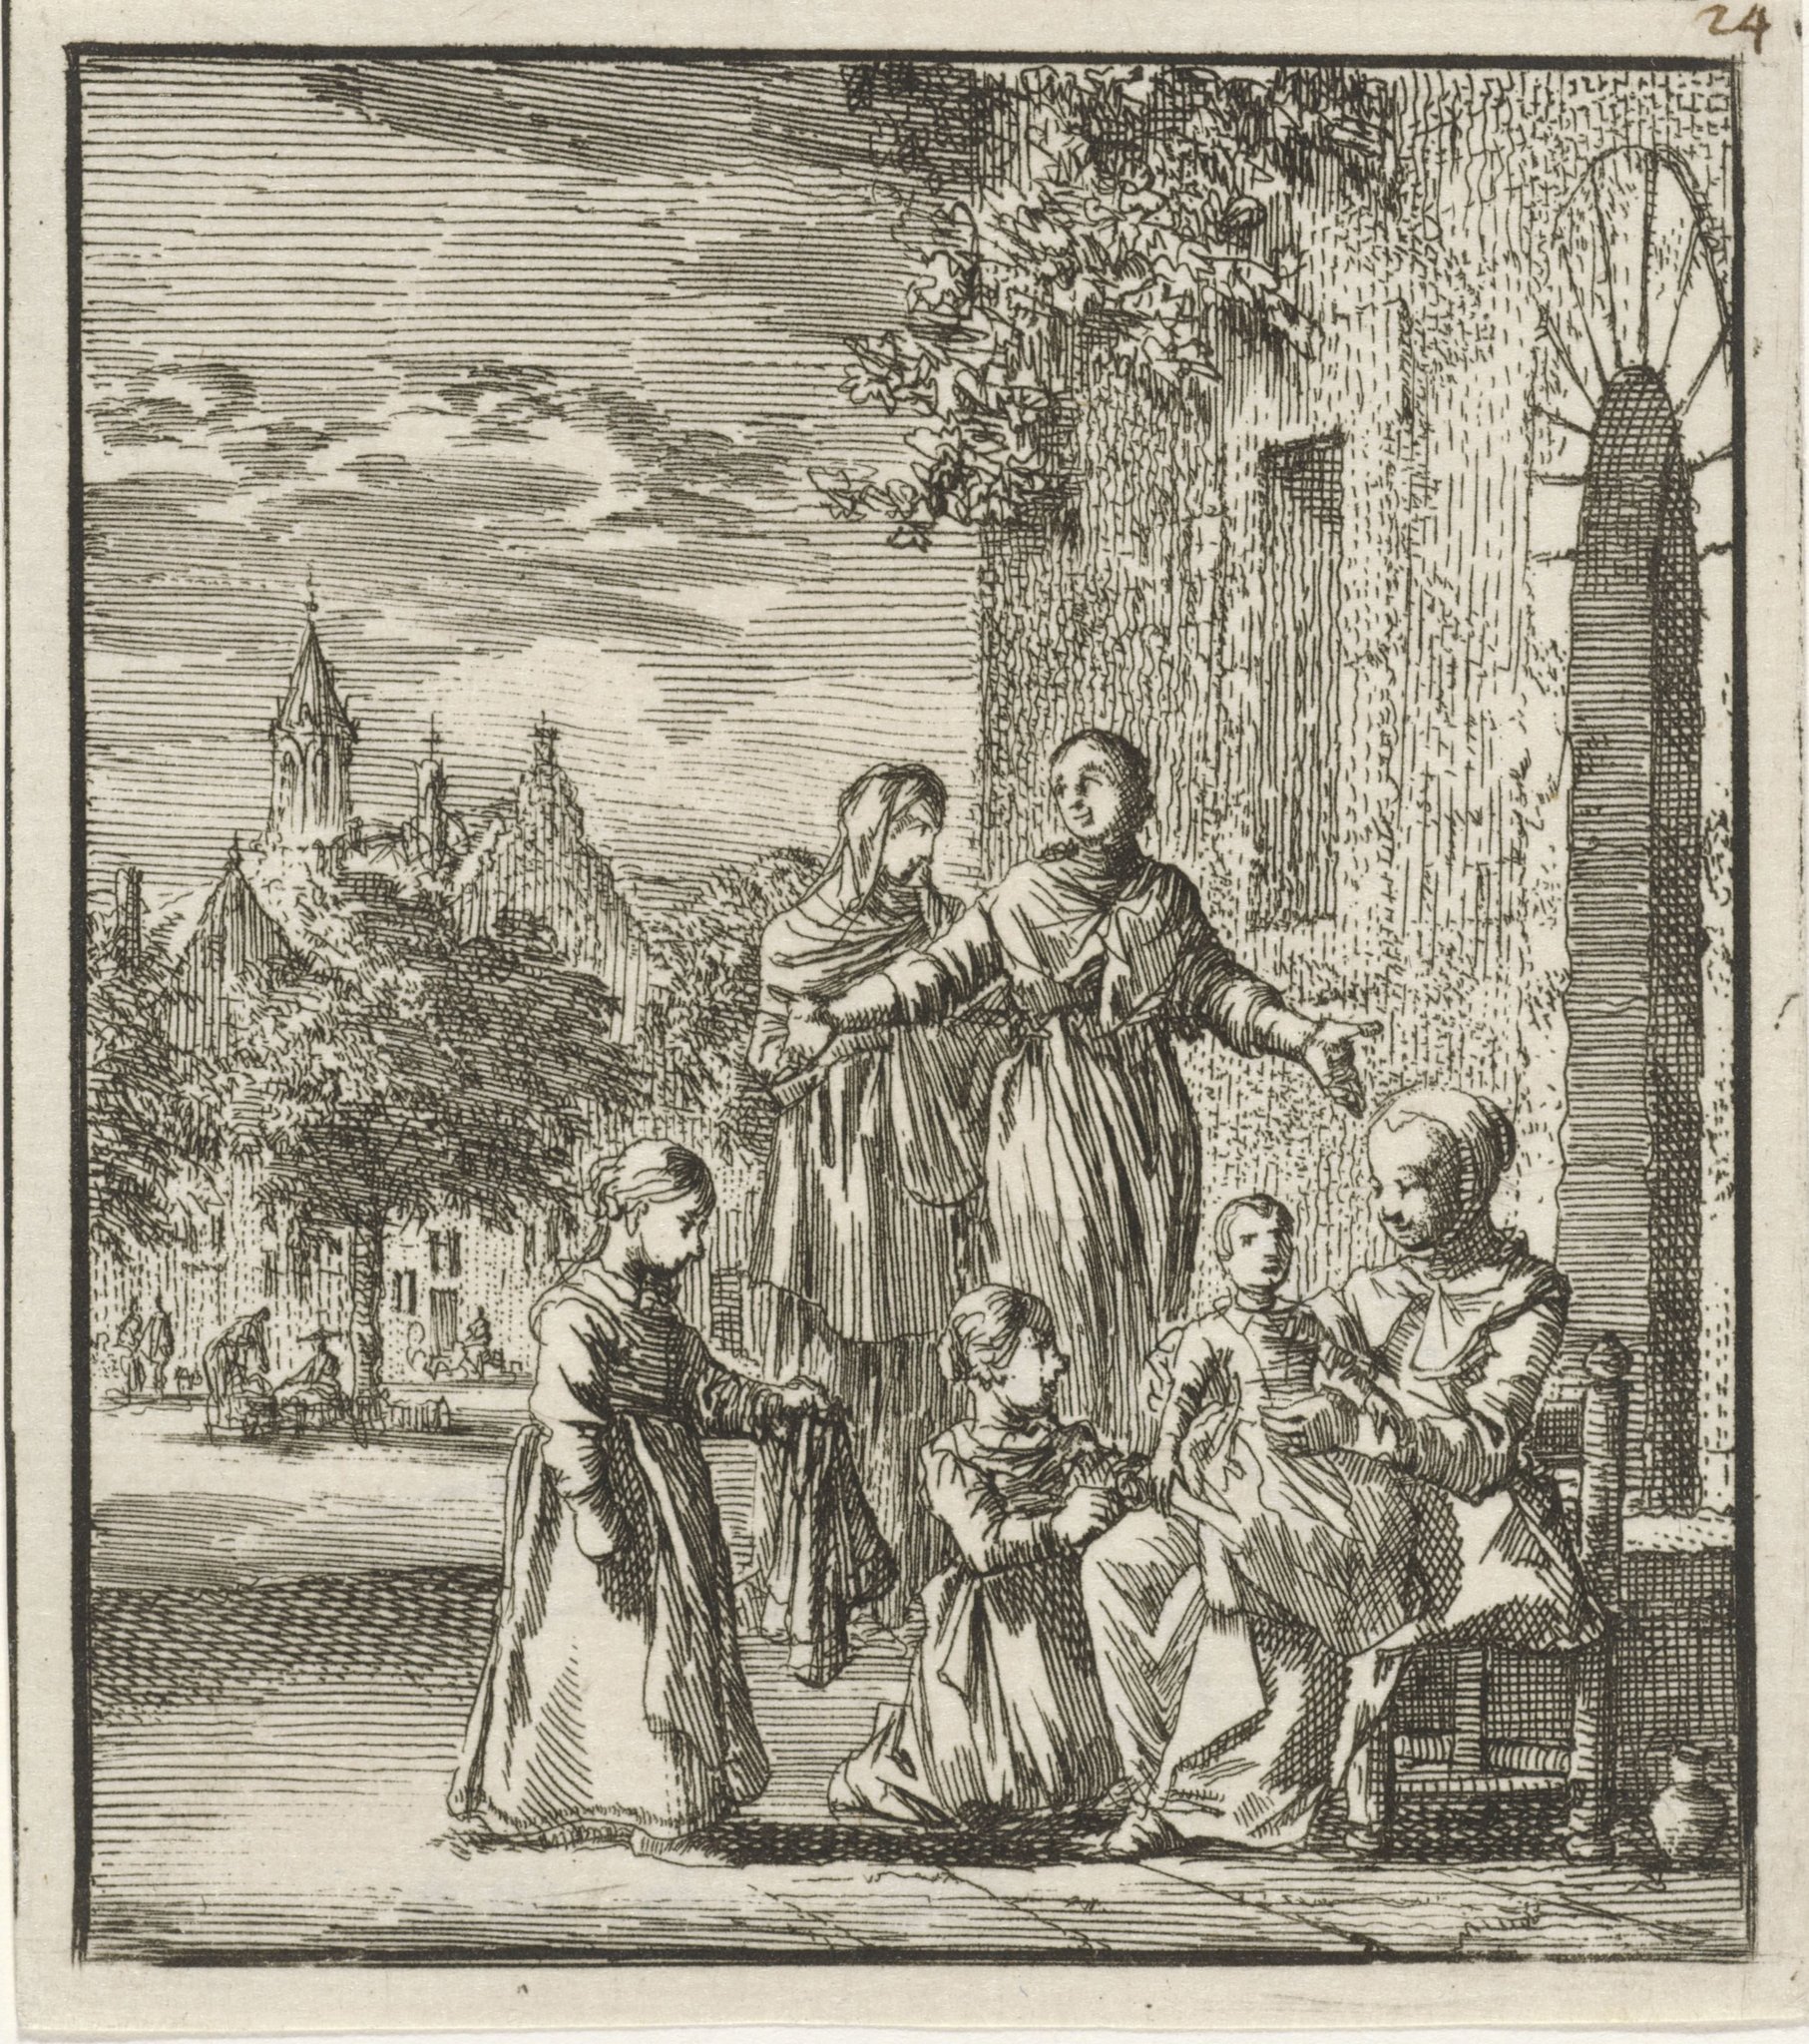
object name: print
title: Drie meisjes spelen op straat met een pop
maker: jan luyken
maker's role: draughtsman, print maker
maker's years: 1649-1712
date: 1712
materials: paper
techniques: etching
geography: amsterdam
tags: (playing with) dolls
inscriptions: collector's mark: Lugt 2228, number: ‘24’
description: Proefdruk van illustratie uit: Luyken, Jan. Des menschen begin, midden en einde. Amsterdam: Wed. Pieter Arentsz II en Cornelis van der Sys, 1712, p. 51.